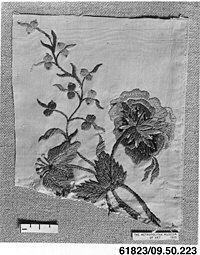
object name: fragment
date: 1701-1800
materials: metal thread, silk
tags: flowers